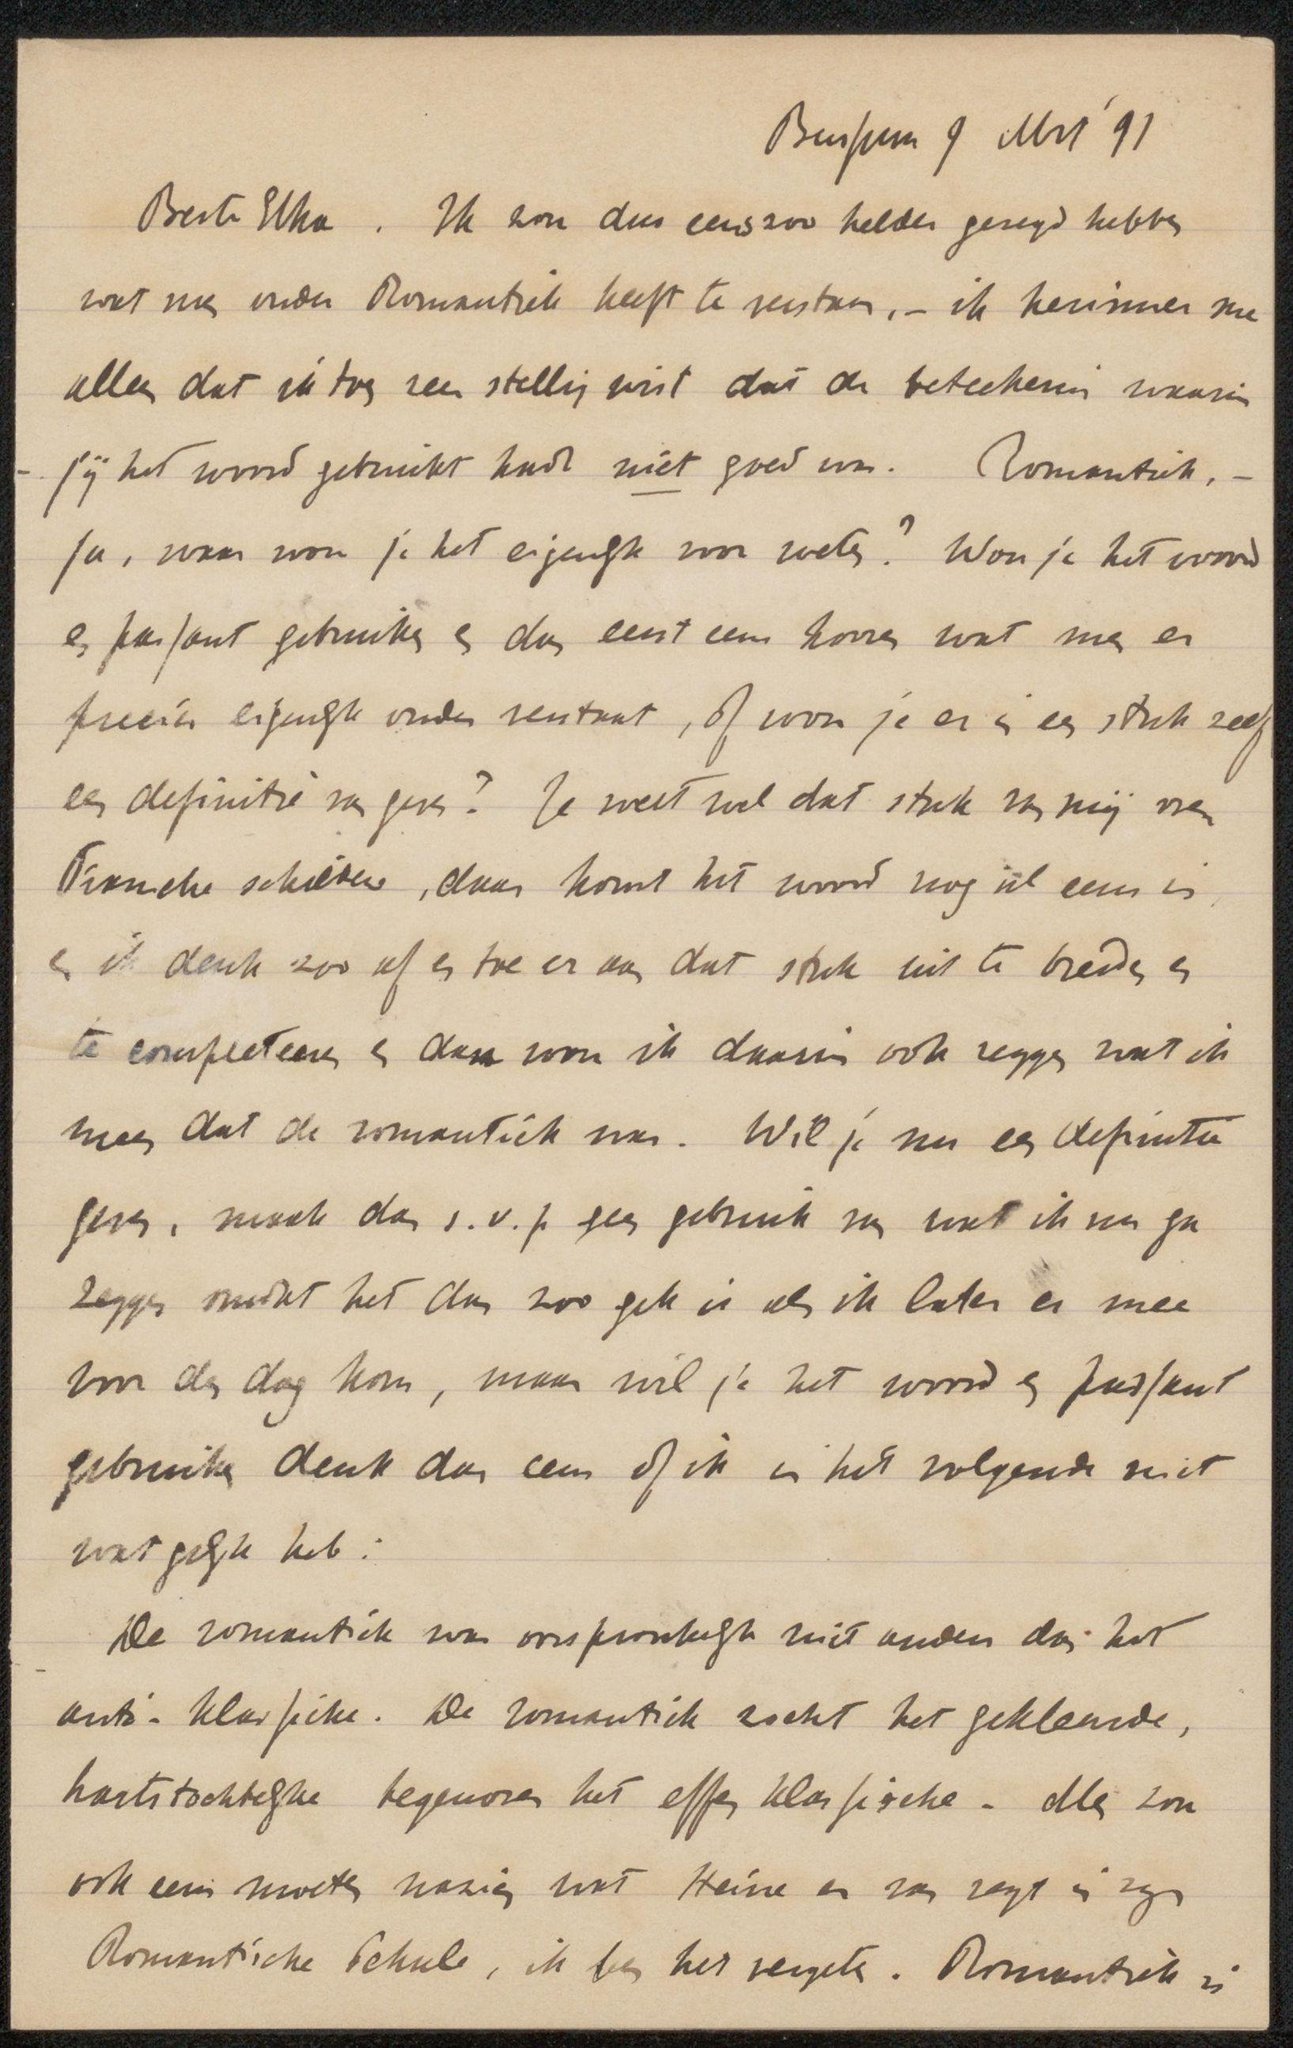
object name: letter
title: Brief aan Etha Fles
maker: jan veth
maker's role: designer, draughtsman, painter, print maker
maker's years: 1864-1925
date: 1891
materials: ink, pencil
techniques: pen, writing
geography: bussum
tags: paris, print maker, draughtsman, eugène delacroix, etha fles, haarlem, utrecht, nicolaas beets, victor hugo, walter scott, trees, painting (including book-illumination, miniature-painting), historical persons (portraits and scenes from the life)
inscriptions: collector's mark: ‘RPK’